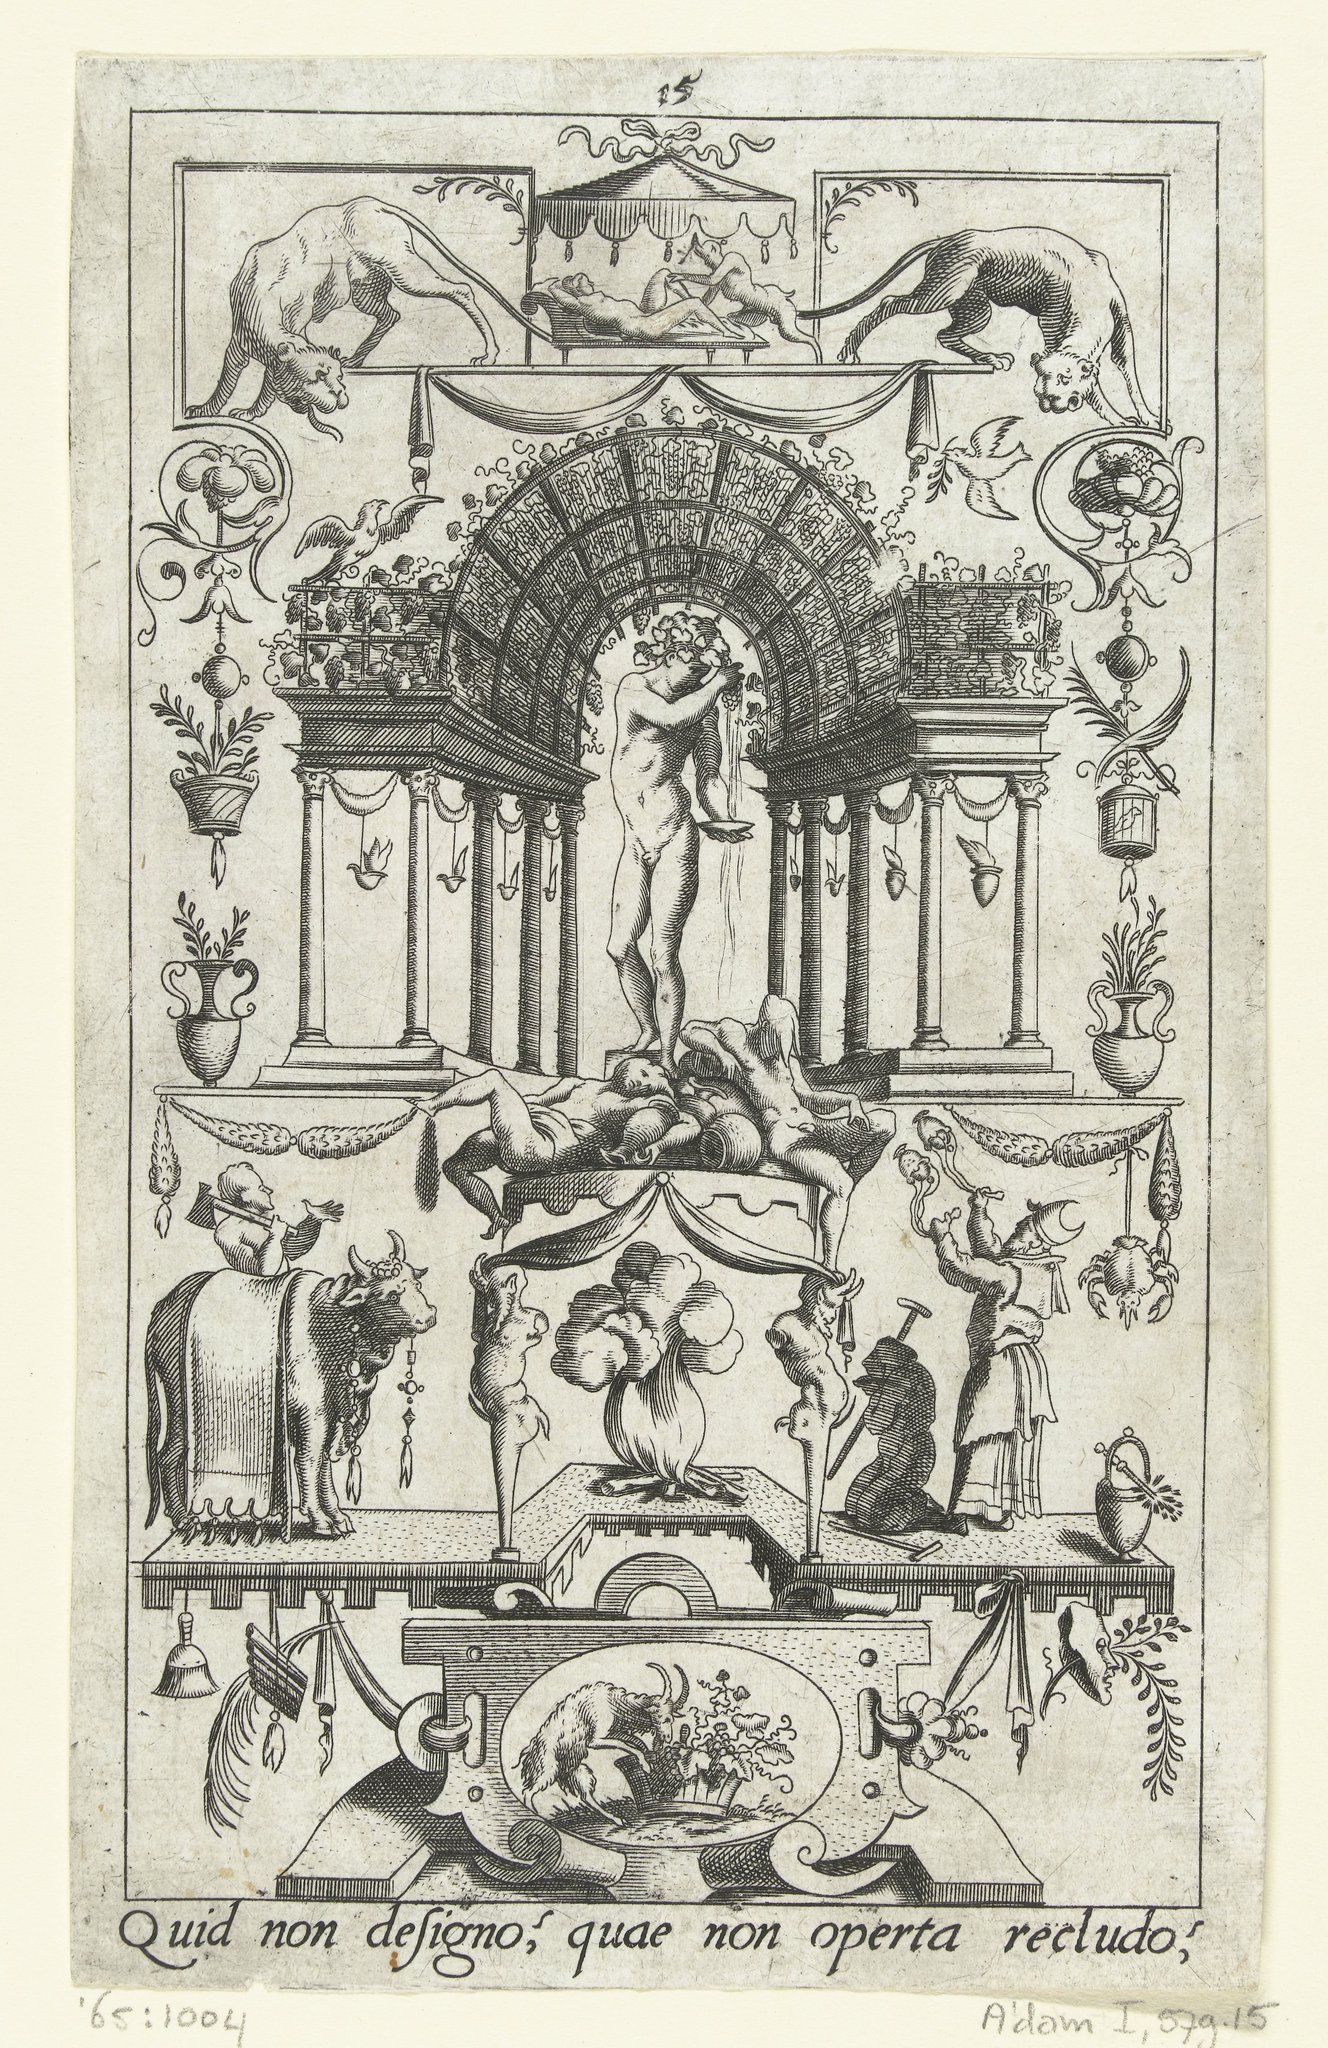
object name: print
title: Goden en godinnen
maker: rené boyvin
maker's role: print maker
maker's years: 1525-1598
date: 1551-1580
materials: paper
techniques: engraving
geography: france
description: Onderaan staat een Latijnse tekst. Uit serie van 16 deels genummerde bladen met vlakdecoraties van goden en godinnen in een omlijsting van grotesken met fantastische wezens, dieren, guirlandes en mascarons.